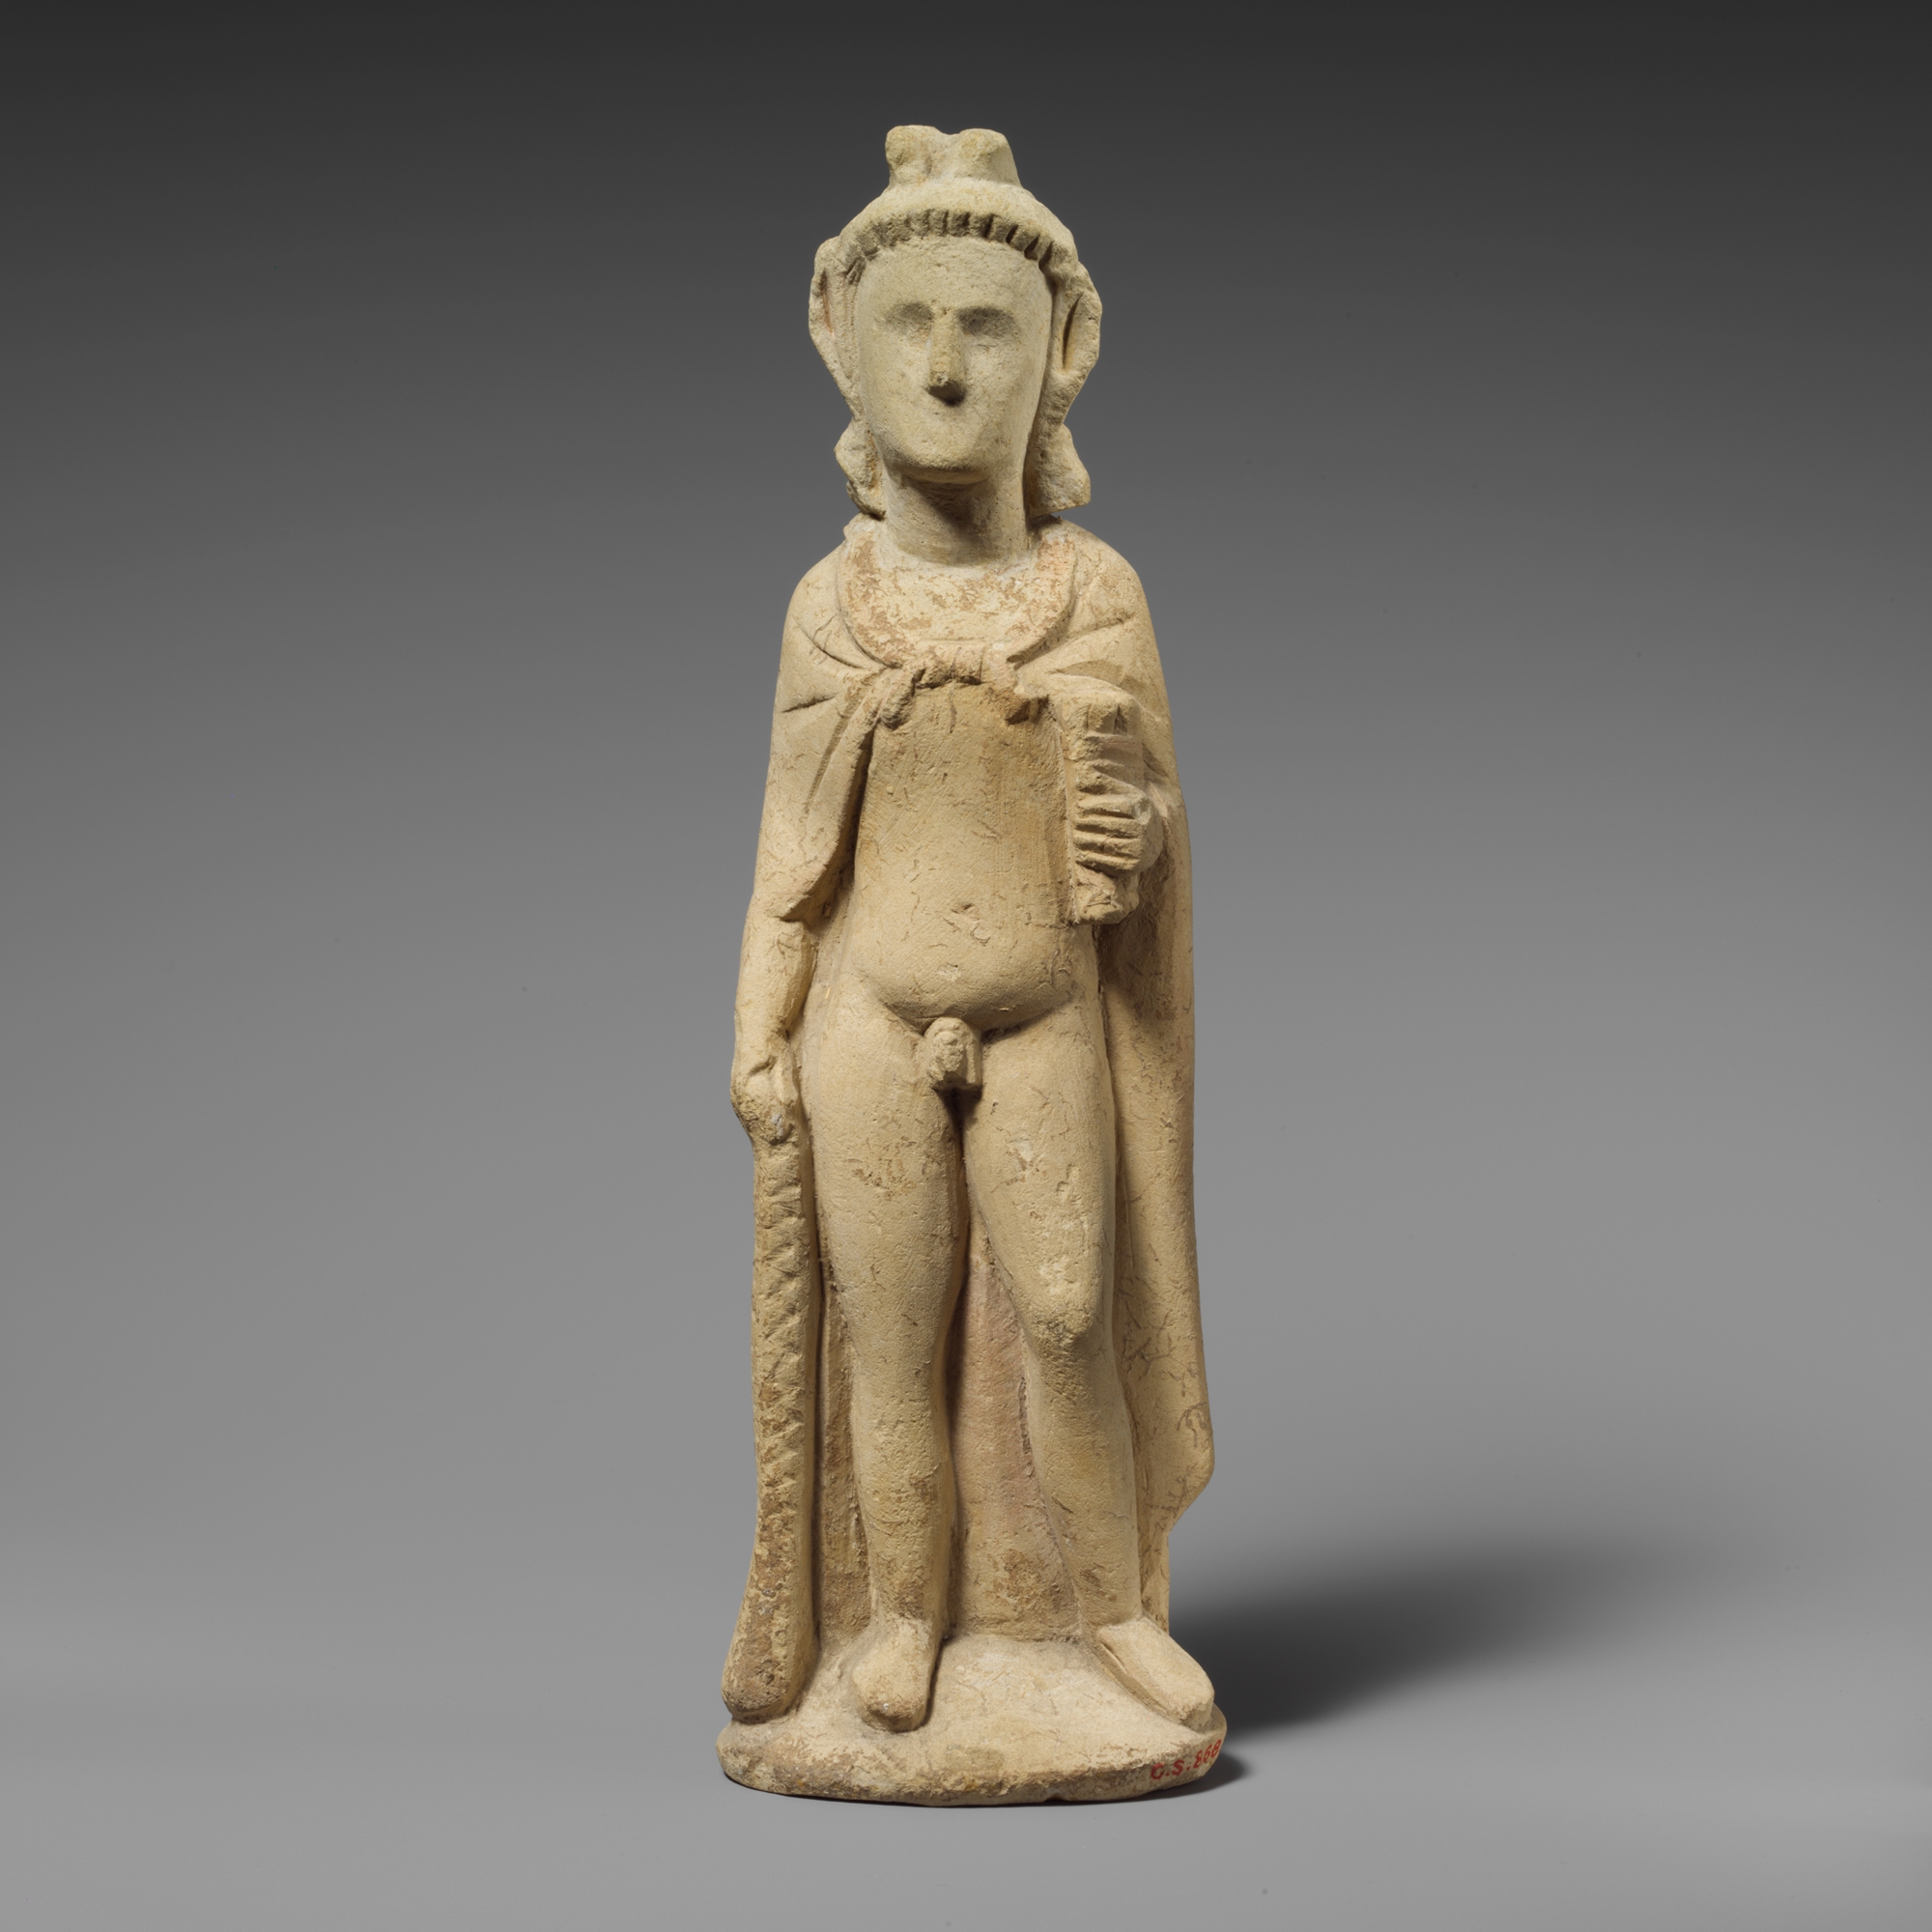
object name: statue of pan or melanthios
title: Limestone statuette of Pan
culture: cypriot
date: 300-1 BCE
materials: limestone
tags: male nudes